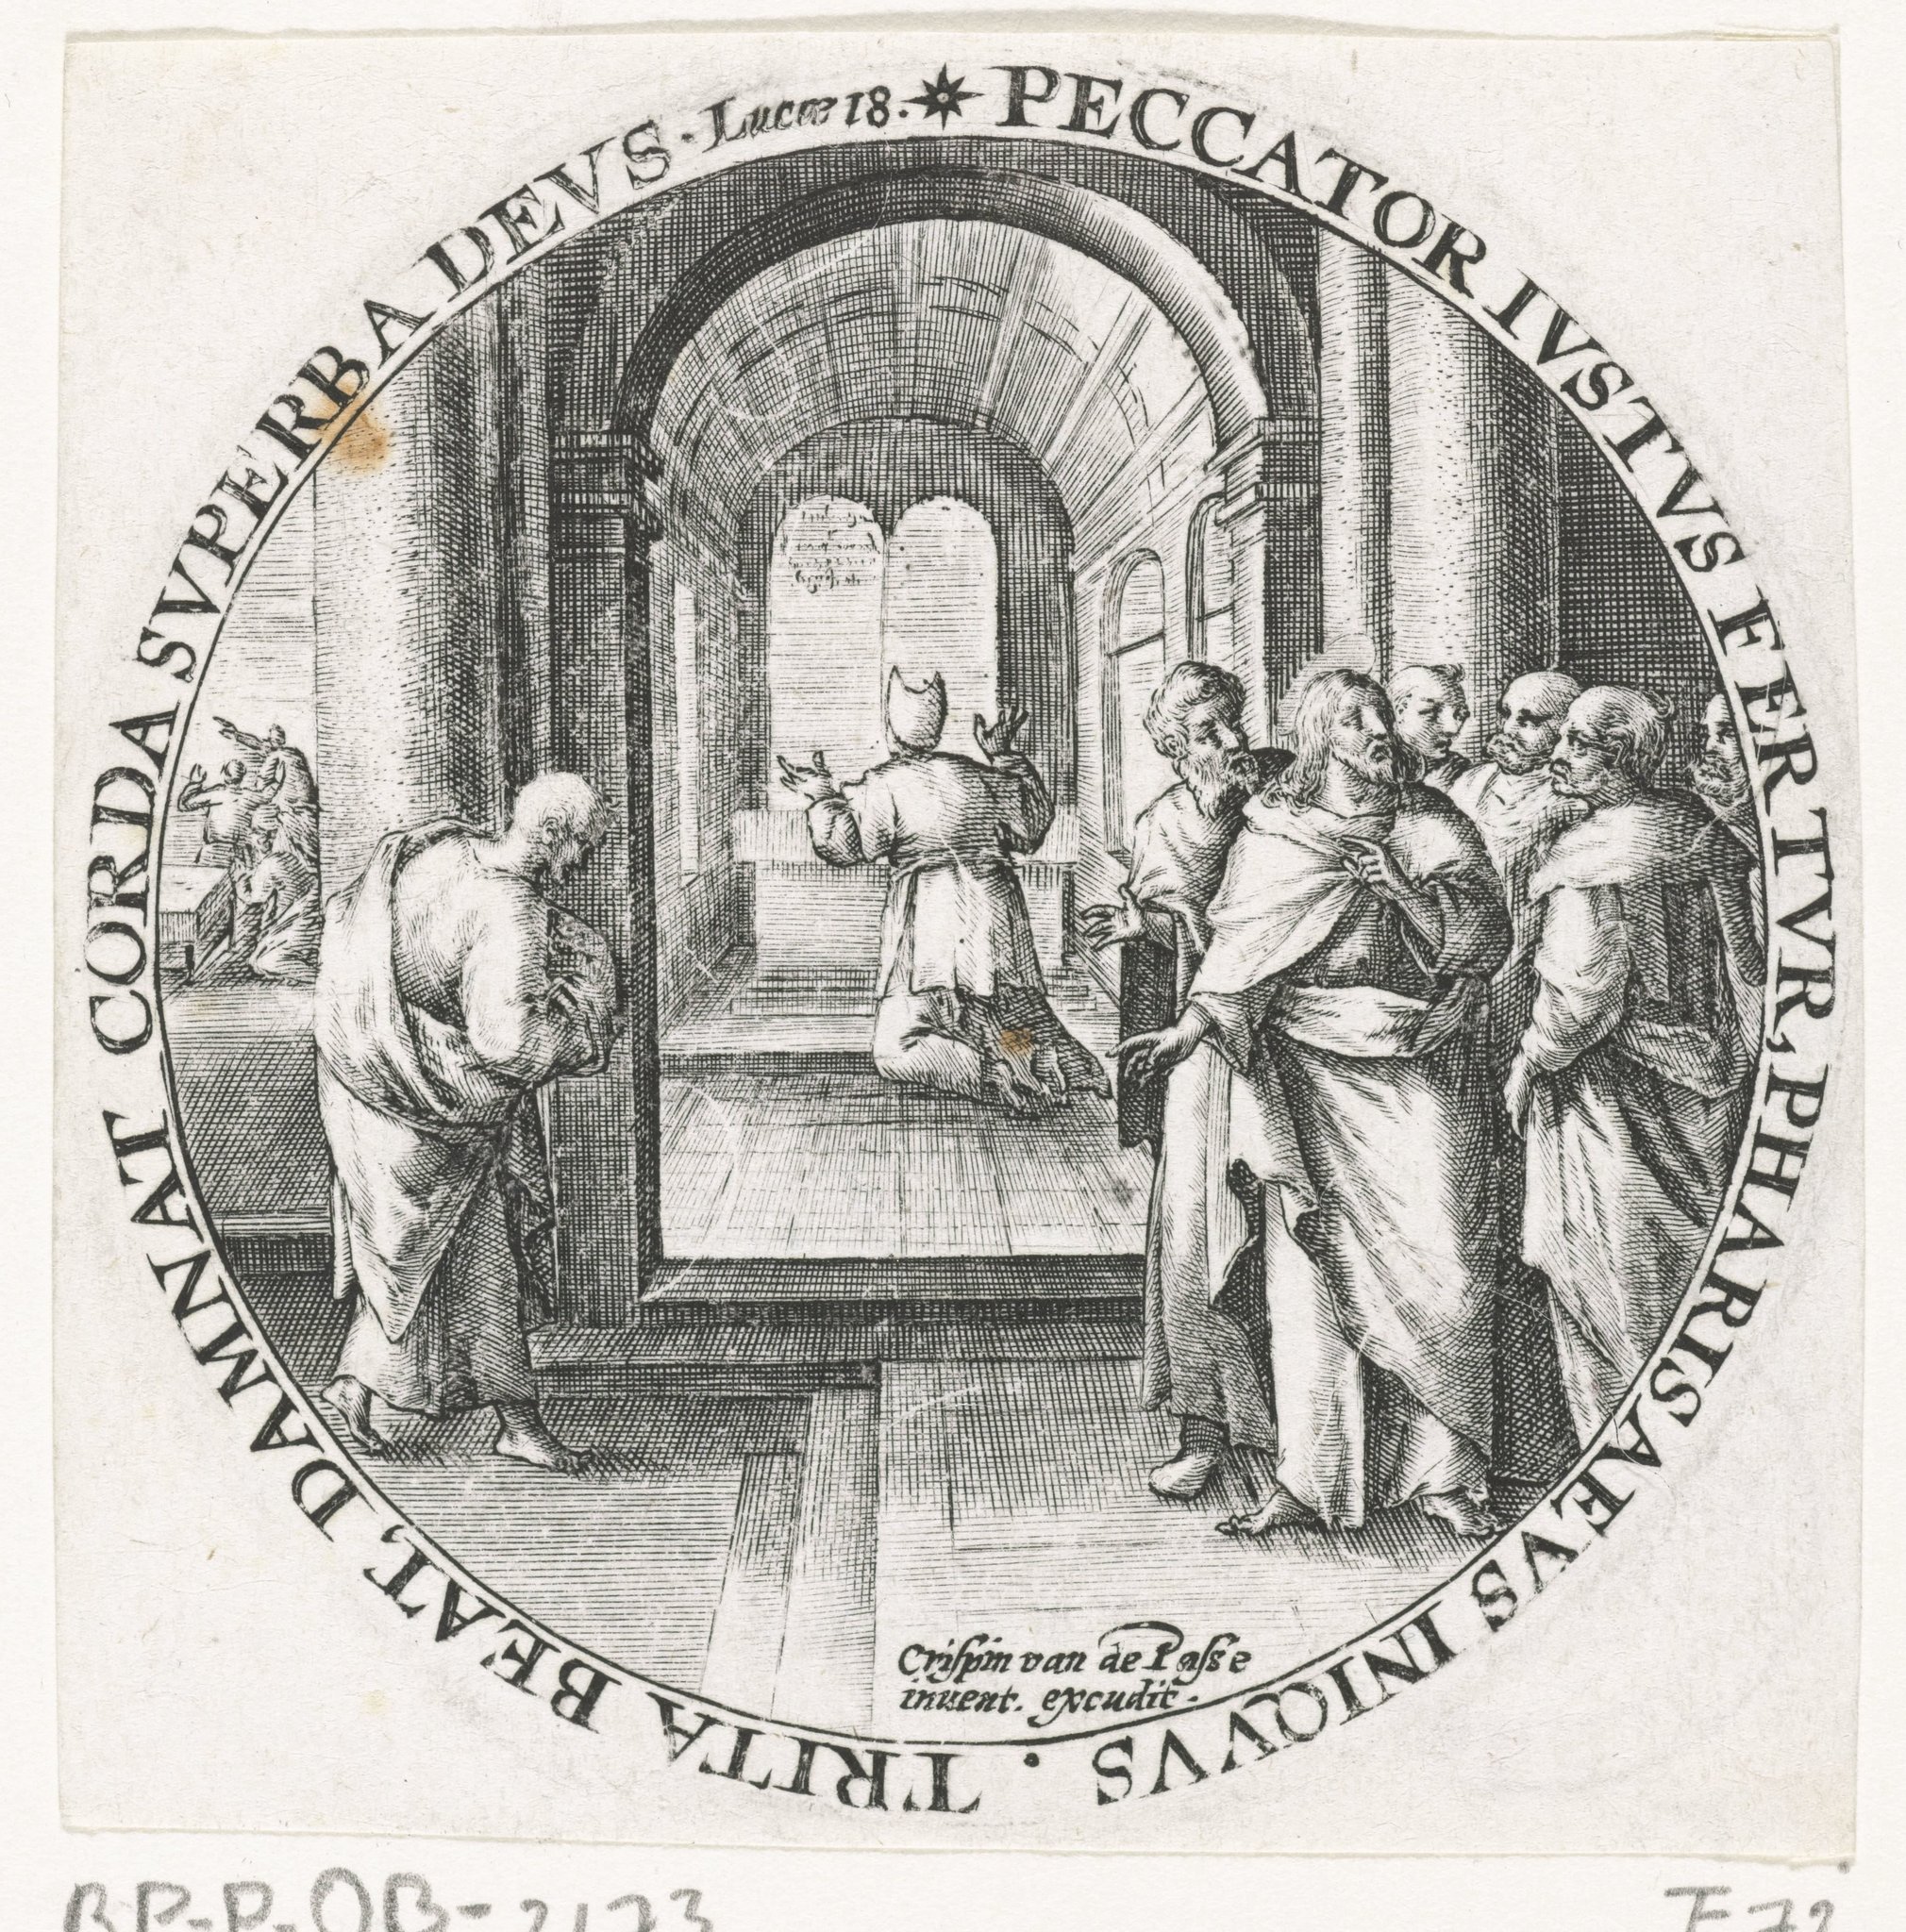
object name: print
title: Gelijkenissen van Christus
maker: crispijn van de passe (i)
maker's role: draughtsman, print maker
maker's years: 1564-1637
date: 1604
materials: paper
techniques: engraving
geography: cologne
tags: the praying pharisee and the repentant publican in the temple (luke 18:10-14)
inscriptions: collector's mark: Lugt 240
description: In de tempel een biddende farizeeër bij het altaar. Op de voorgrond een tollenaar die niet dichtbij durft te komen. Hij vraagt God om vergiffenis van zijn zonden (Luc. 18). De voorstelling is gevat in een ronde omlijsting met een randschrift in het Latijn. Prent uit een serie met gelijkenissen van Christus.